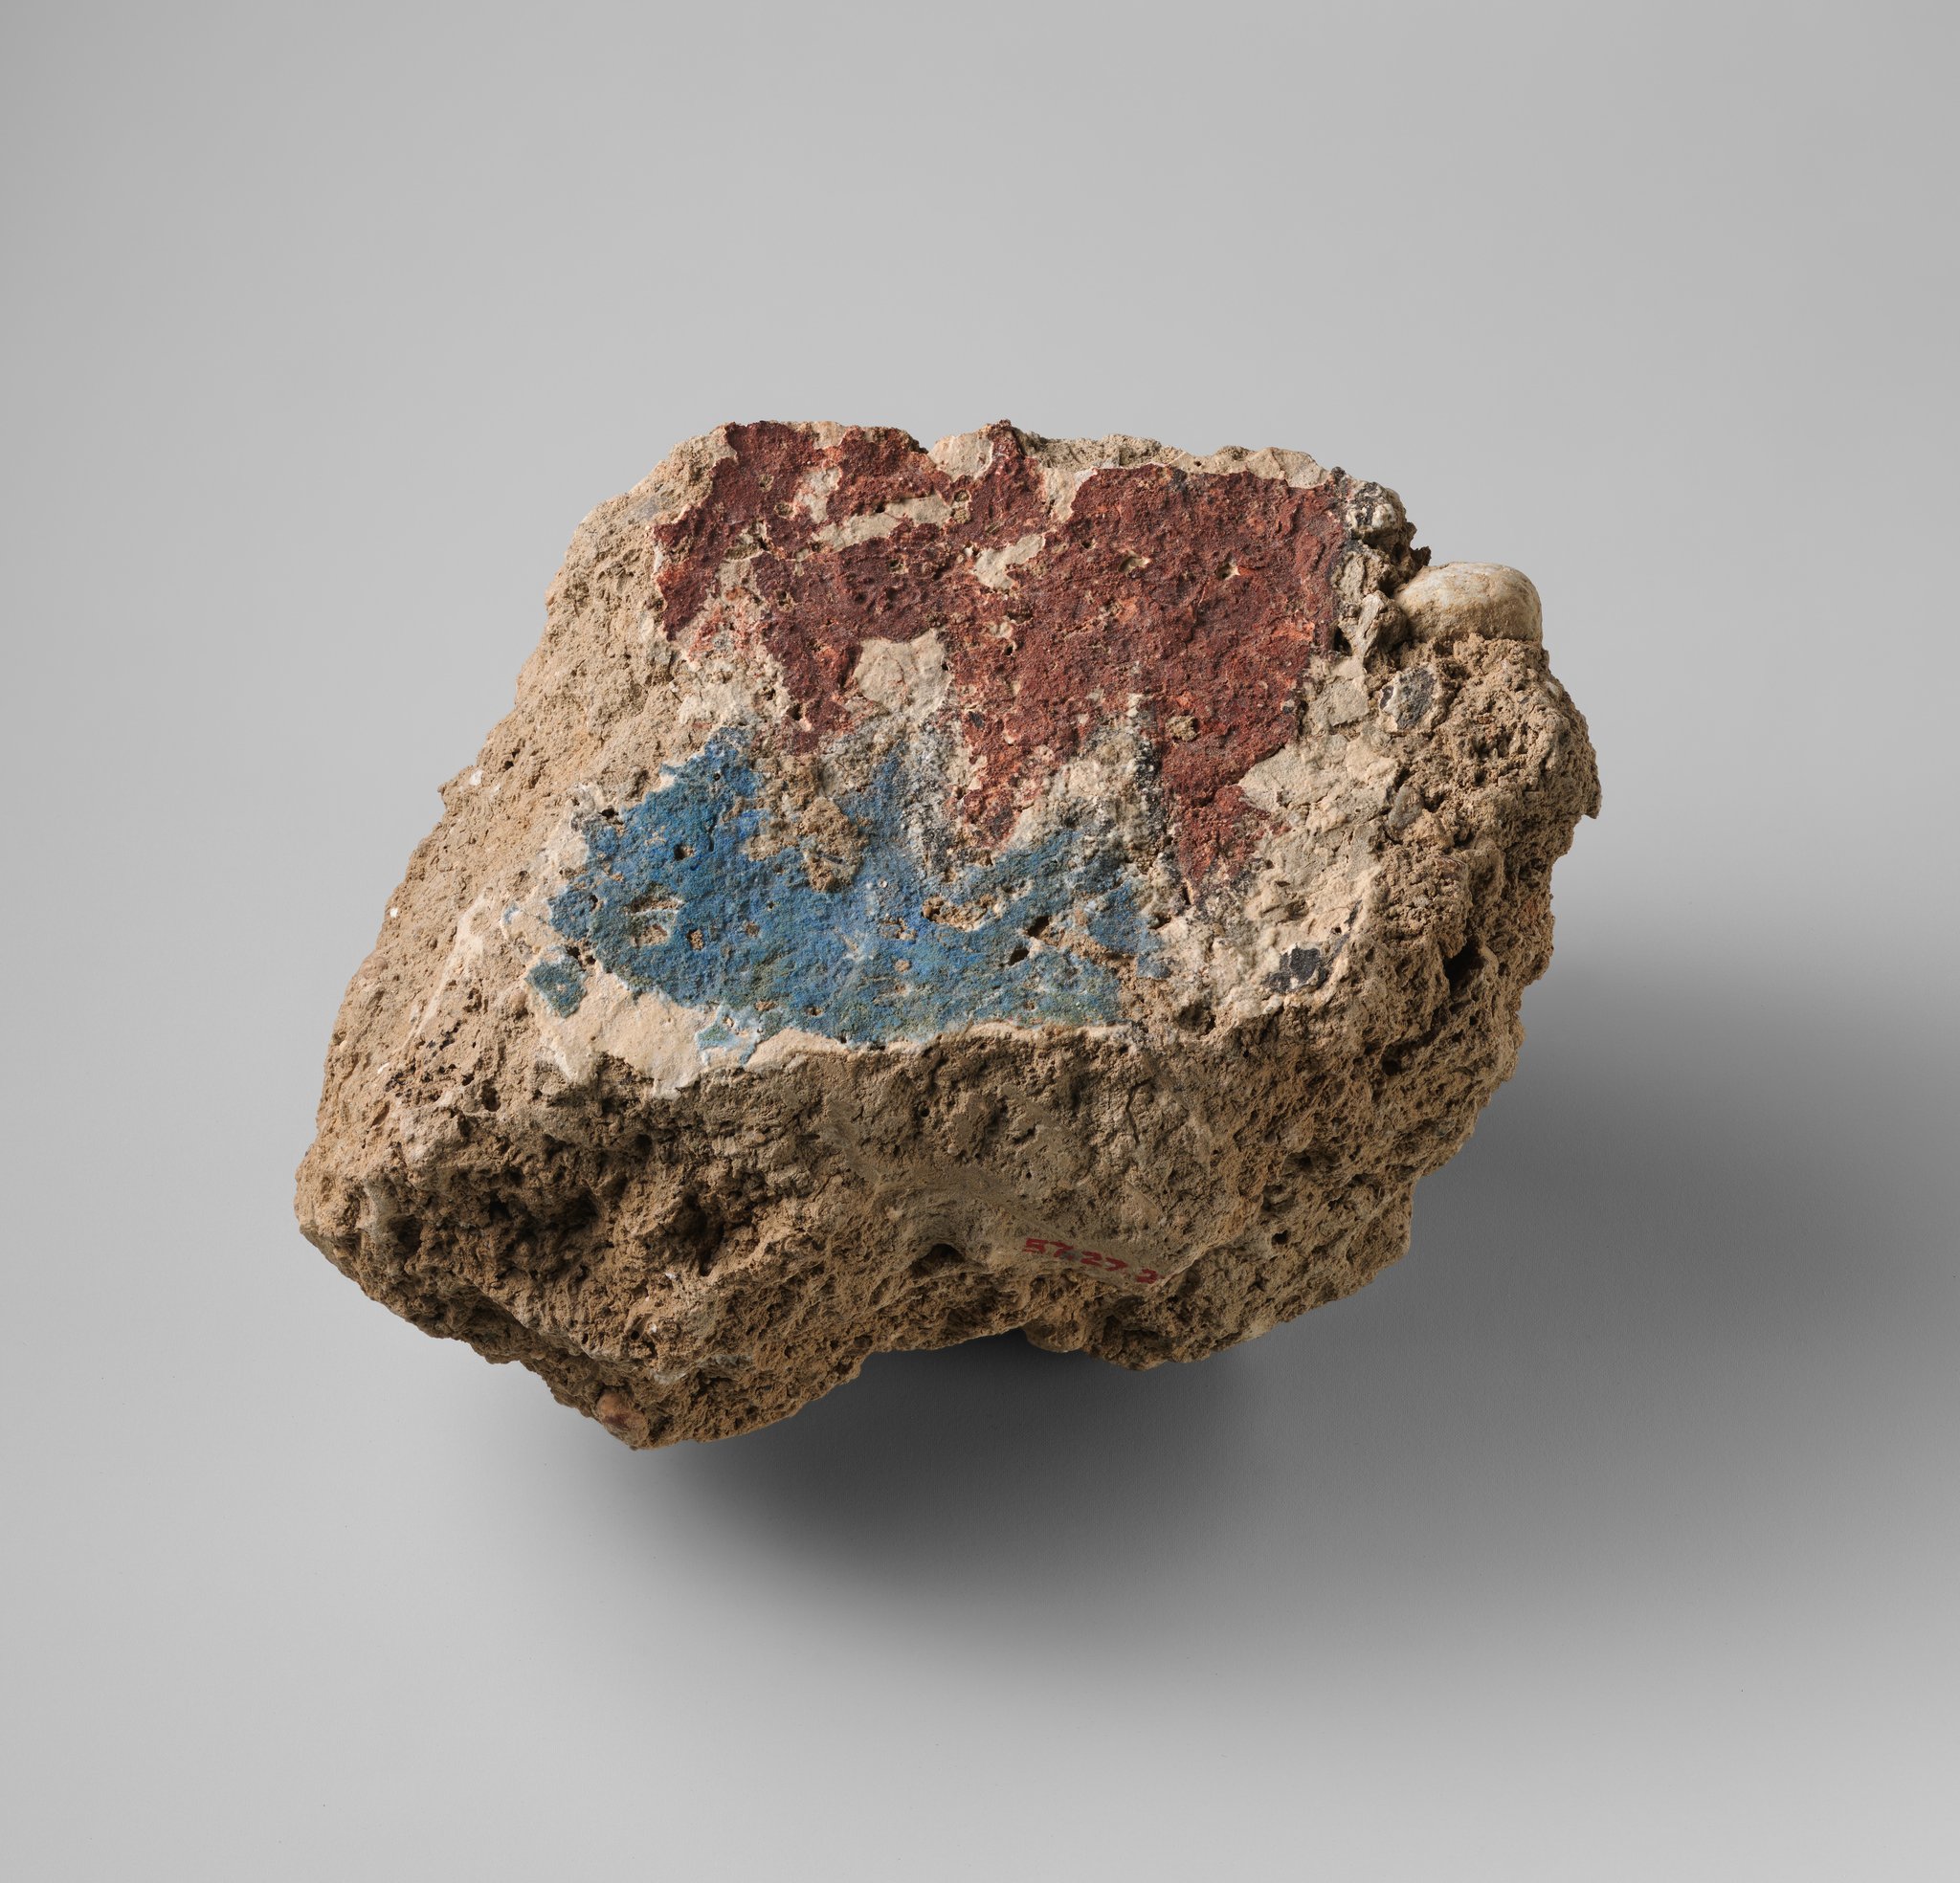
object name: painted plaster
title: Plaster with painted chevrons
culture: assyrian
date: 900-601 BCE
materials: paint, plaster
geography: mesopotamia